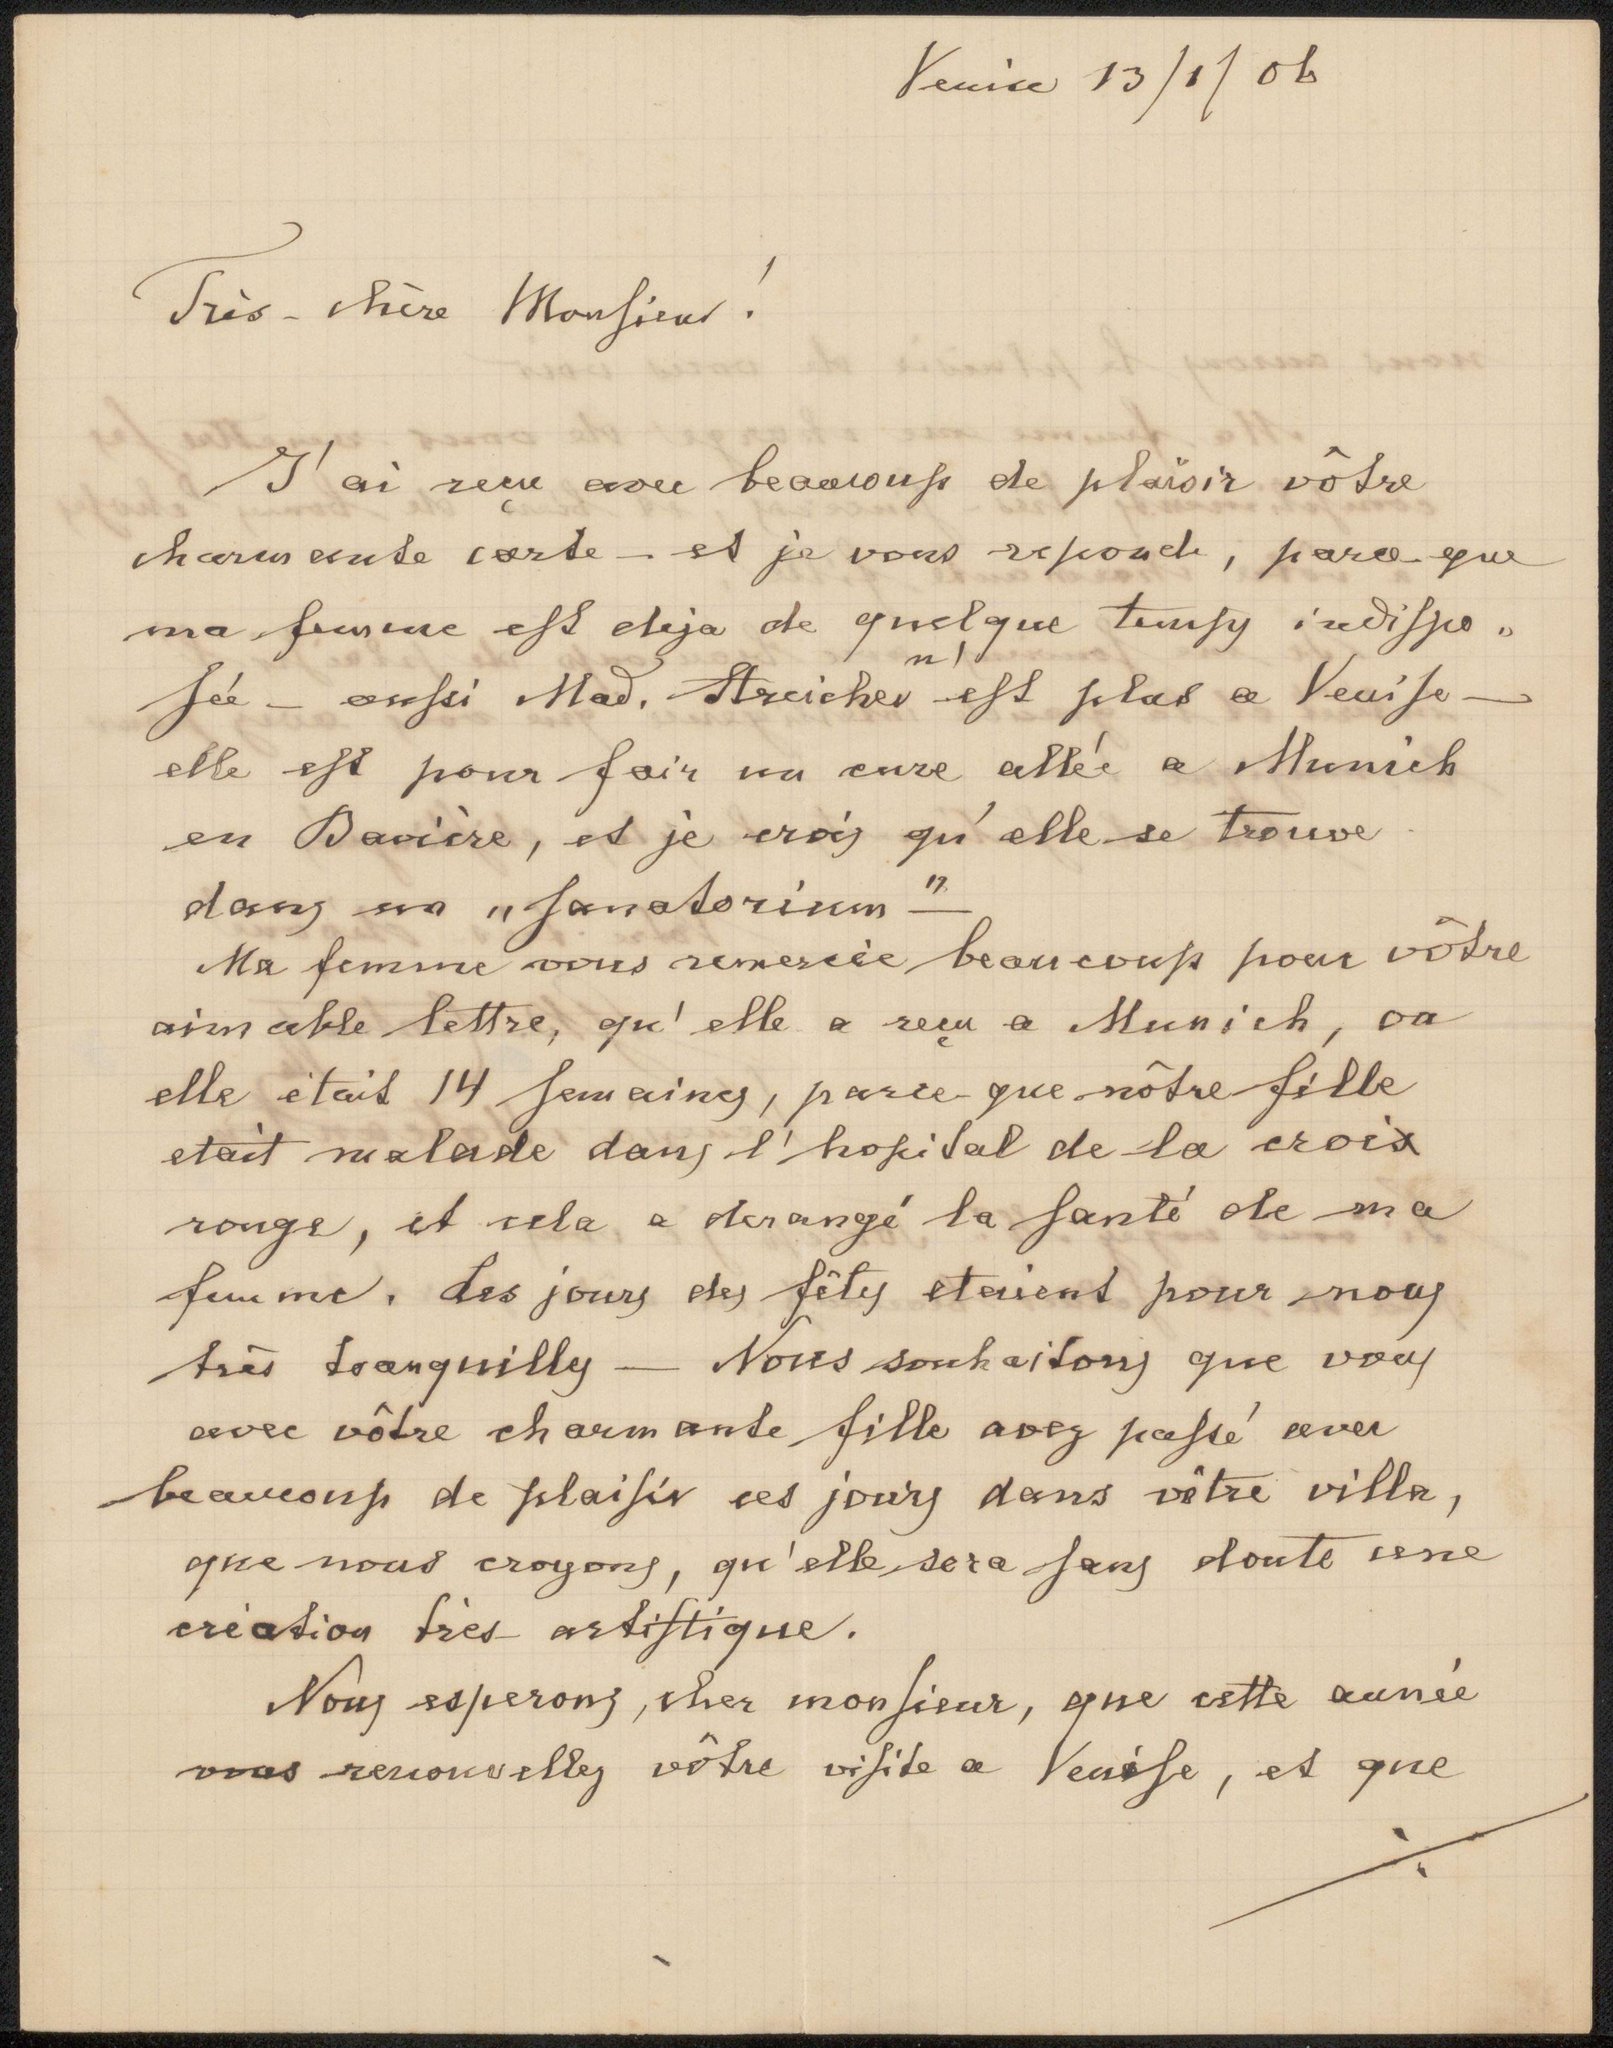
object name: letter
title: Brief aan Philip Zilcken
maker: Anonymous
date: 1906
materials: ink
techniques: pen, writing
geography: venice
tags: painter, draughtsman, jan toorop, philip zilcken, music, diseases, venice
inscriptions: collector's mark: ‘RPK’, watermark